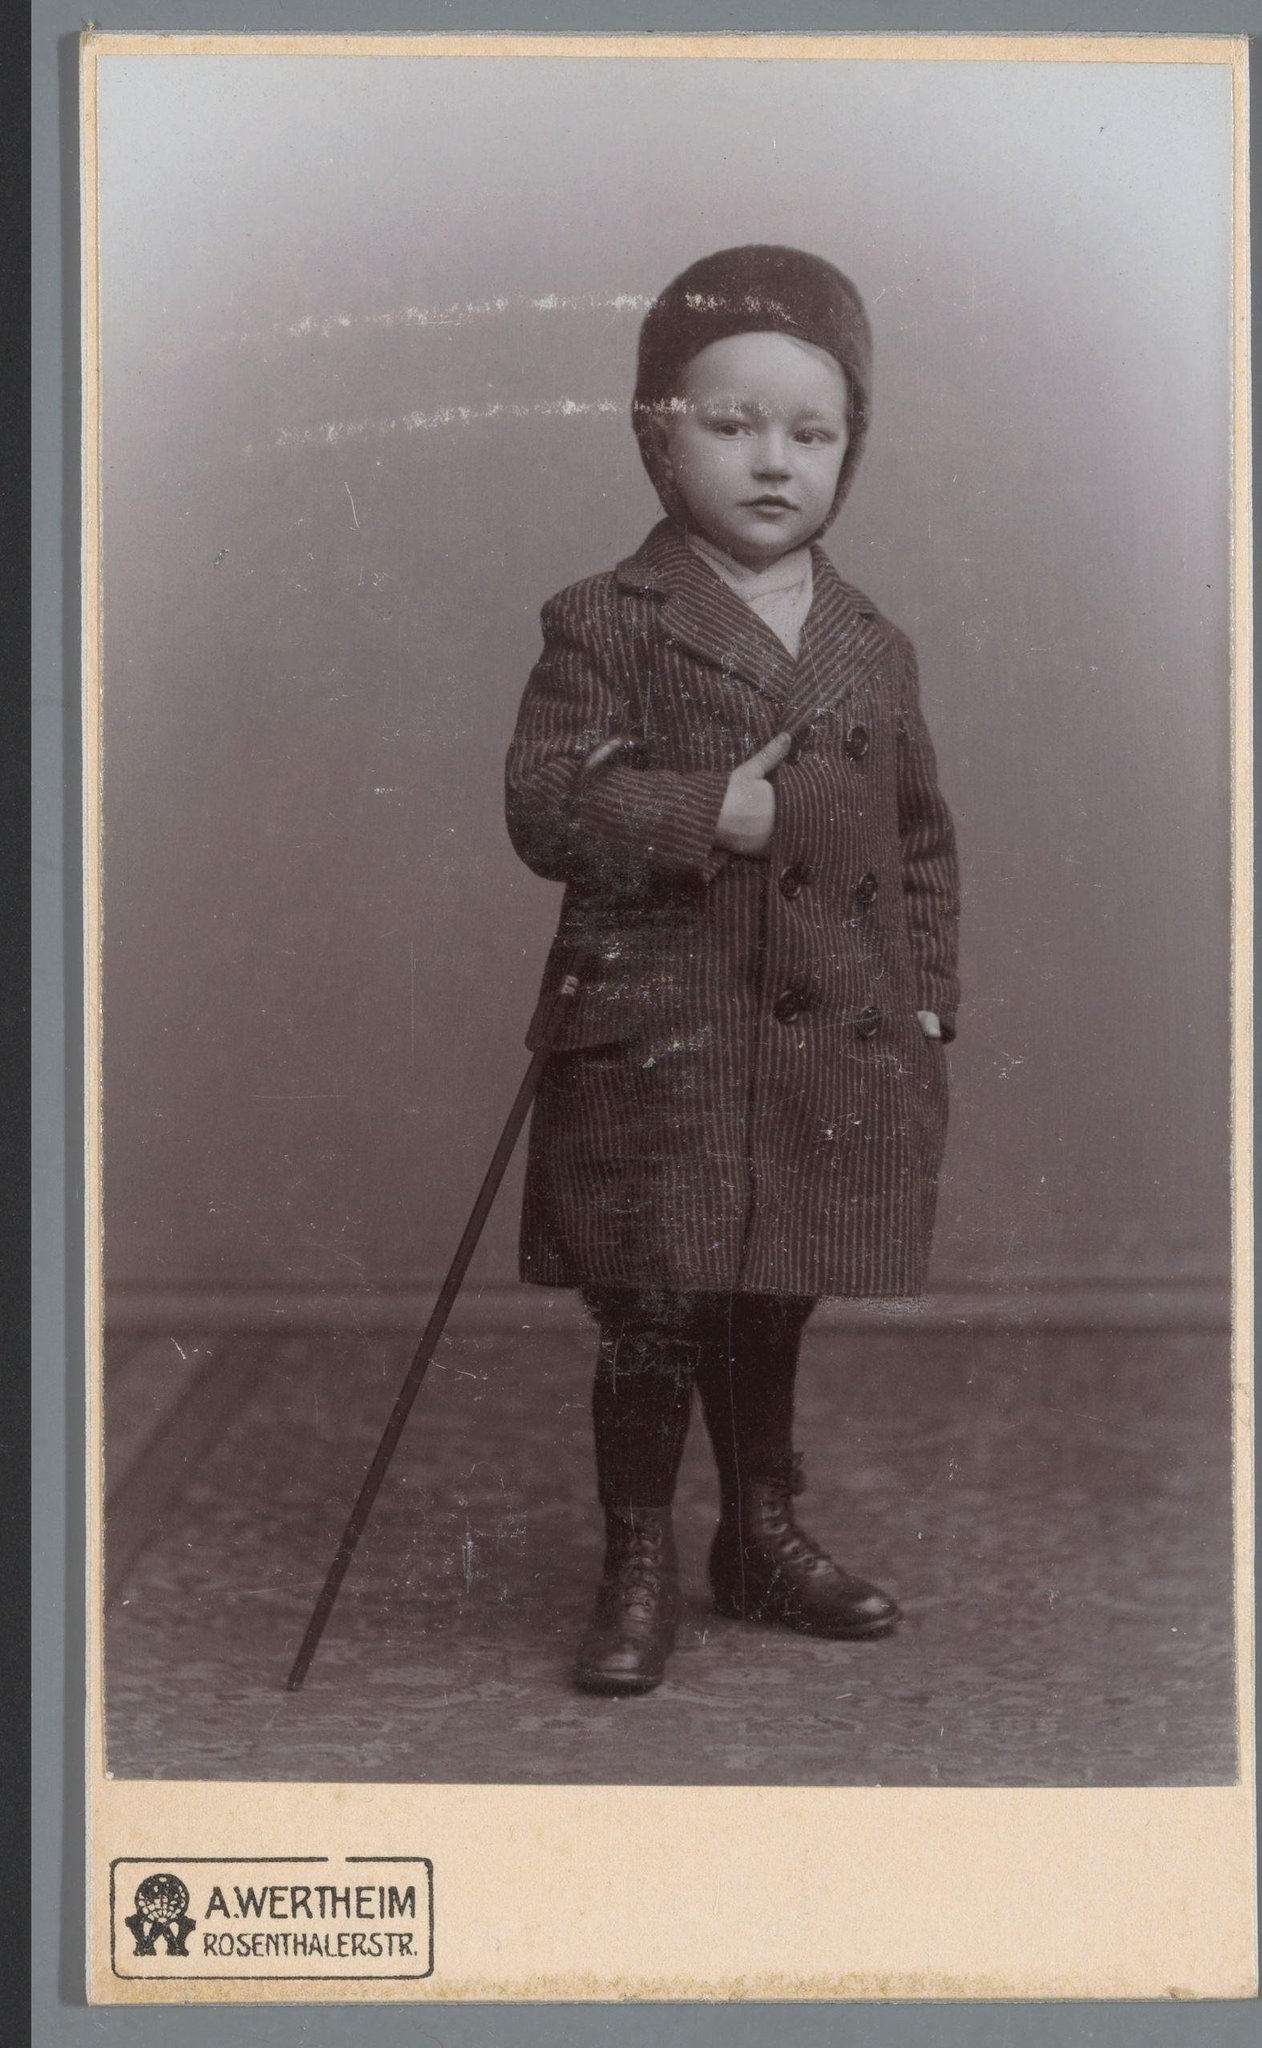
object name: photograph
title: Portret van een onbekende jongen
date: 1900-1914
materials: paper, cardboard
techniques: collodion silver print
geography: leipzig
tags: boy (child between toddler and youth), anonymous historical person portrayed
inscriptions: address: ‘ROSENTHALERSTR.’, number: ‘5544’